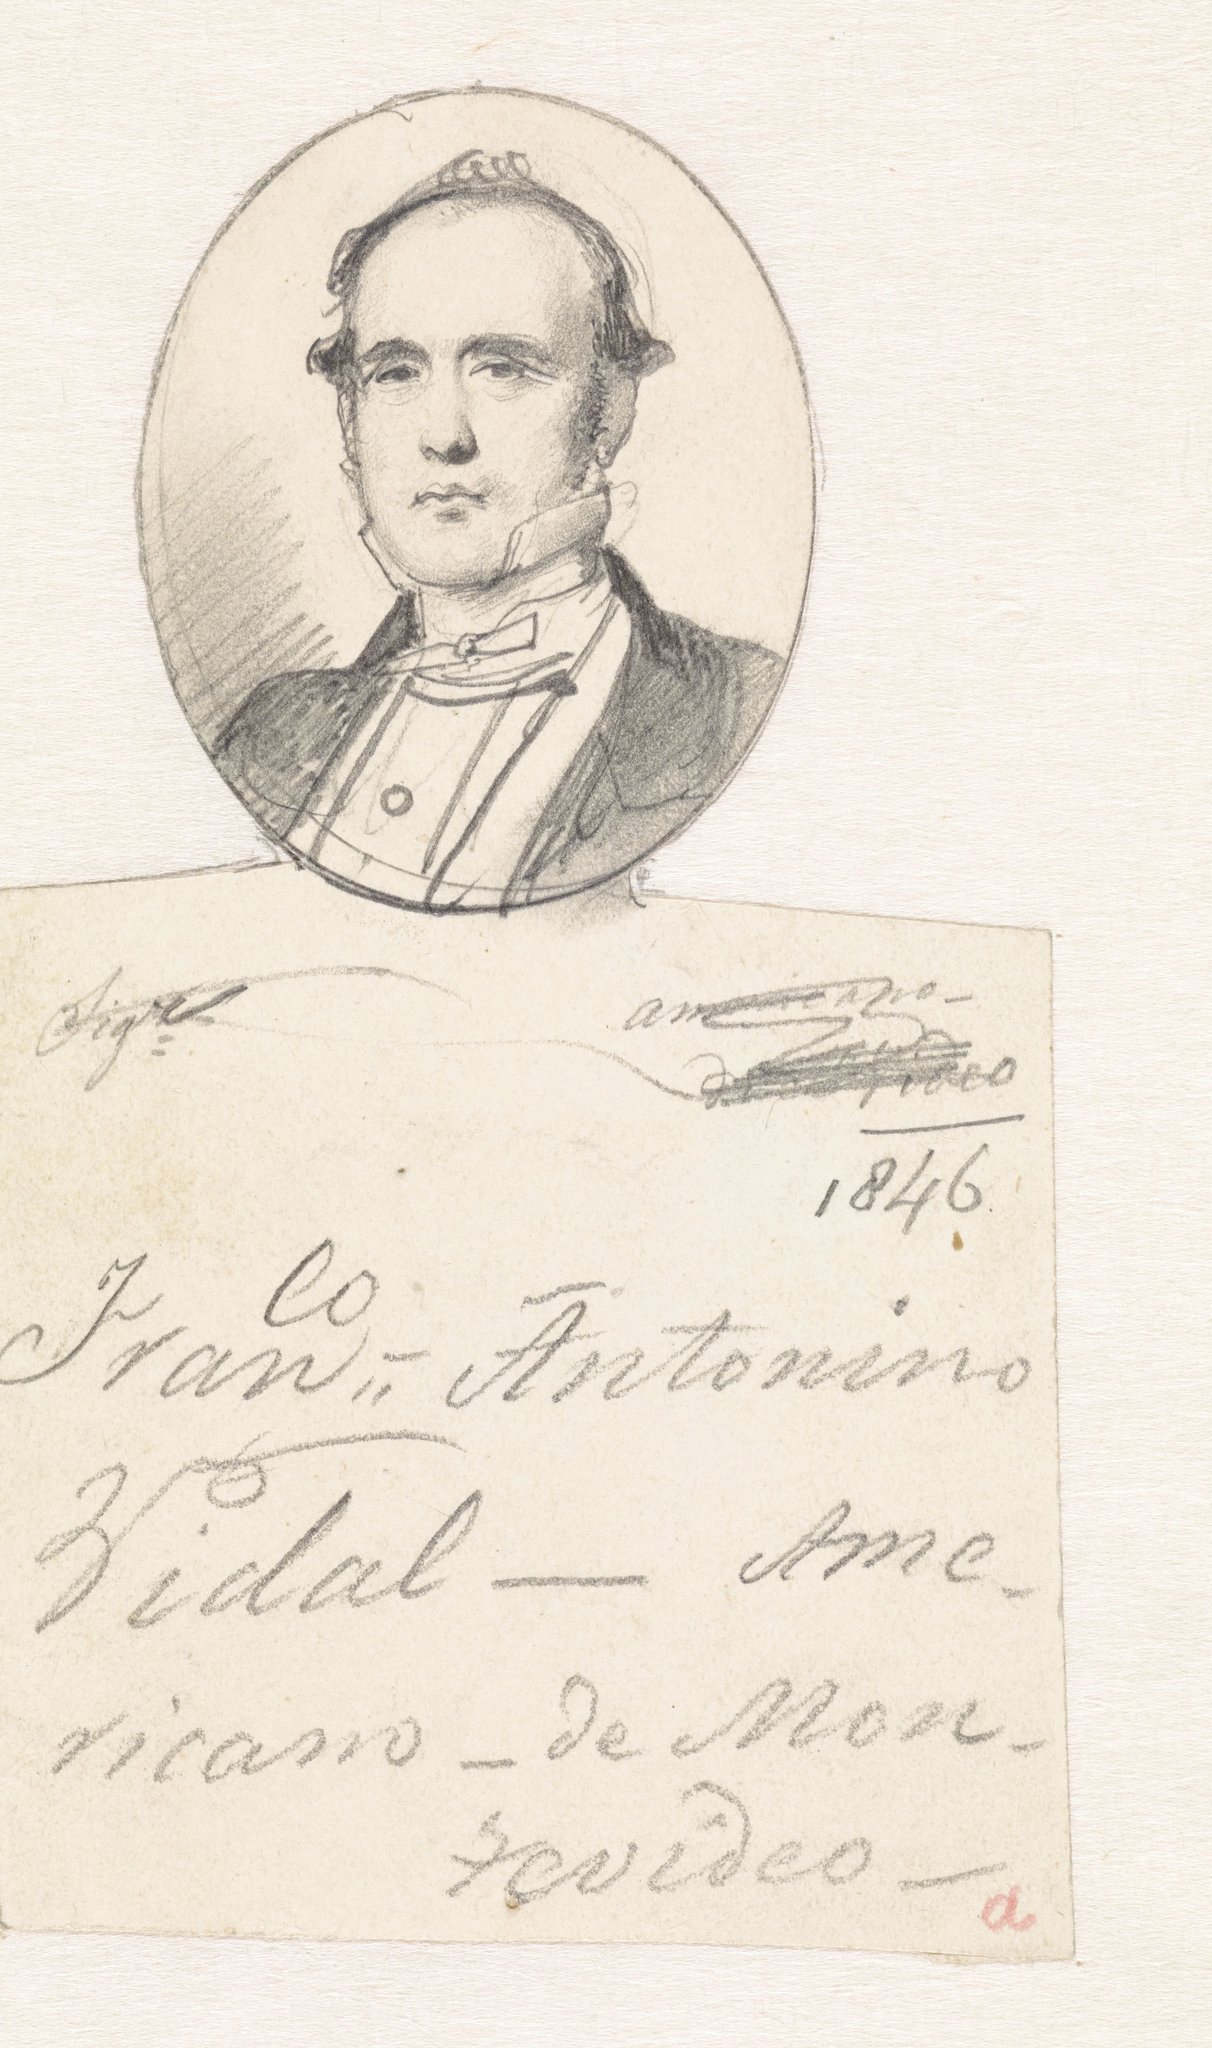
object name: drawing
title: Portret van Franco Antonio Vidal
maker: johan hendrik koelman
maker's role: draughtsman, print maker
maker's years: 1820-1887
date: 1846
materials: paper, pencil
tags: historical persons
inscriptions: date: ‘1846’, inscription: ‘Portret van Franco Antonino Vidal, Americano de Montevideo’